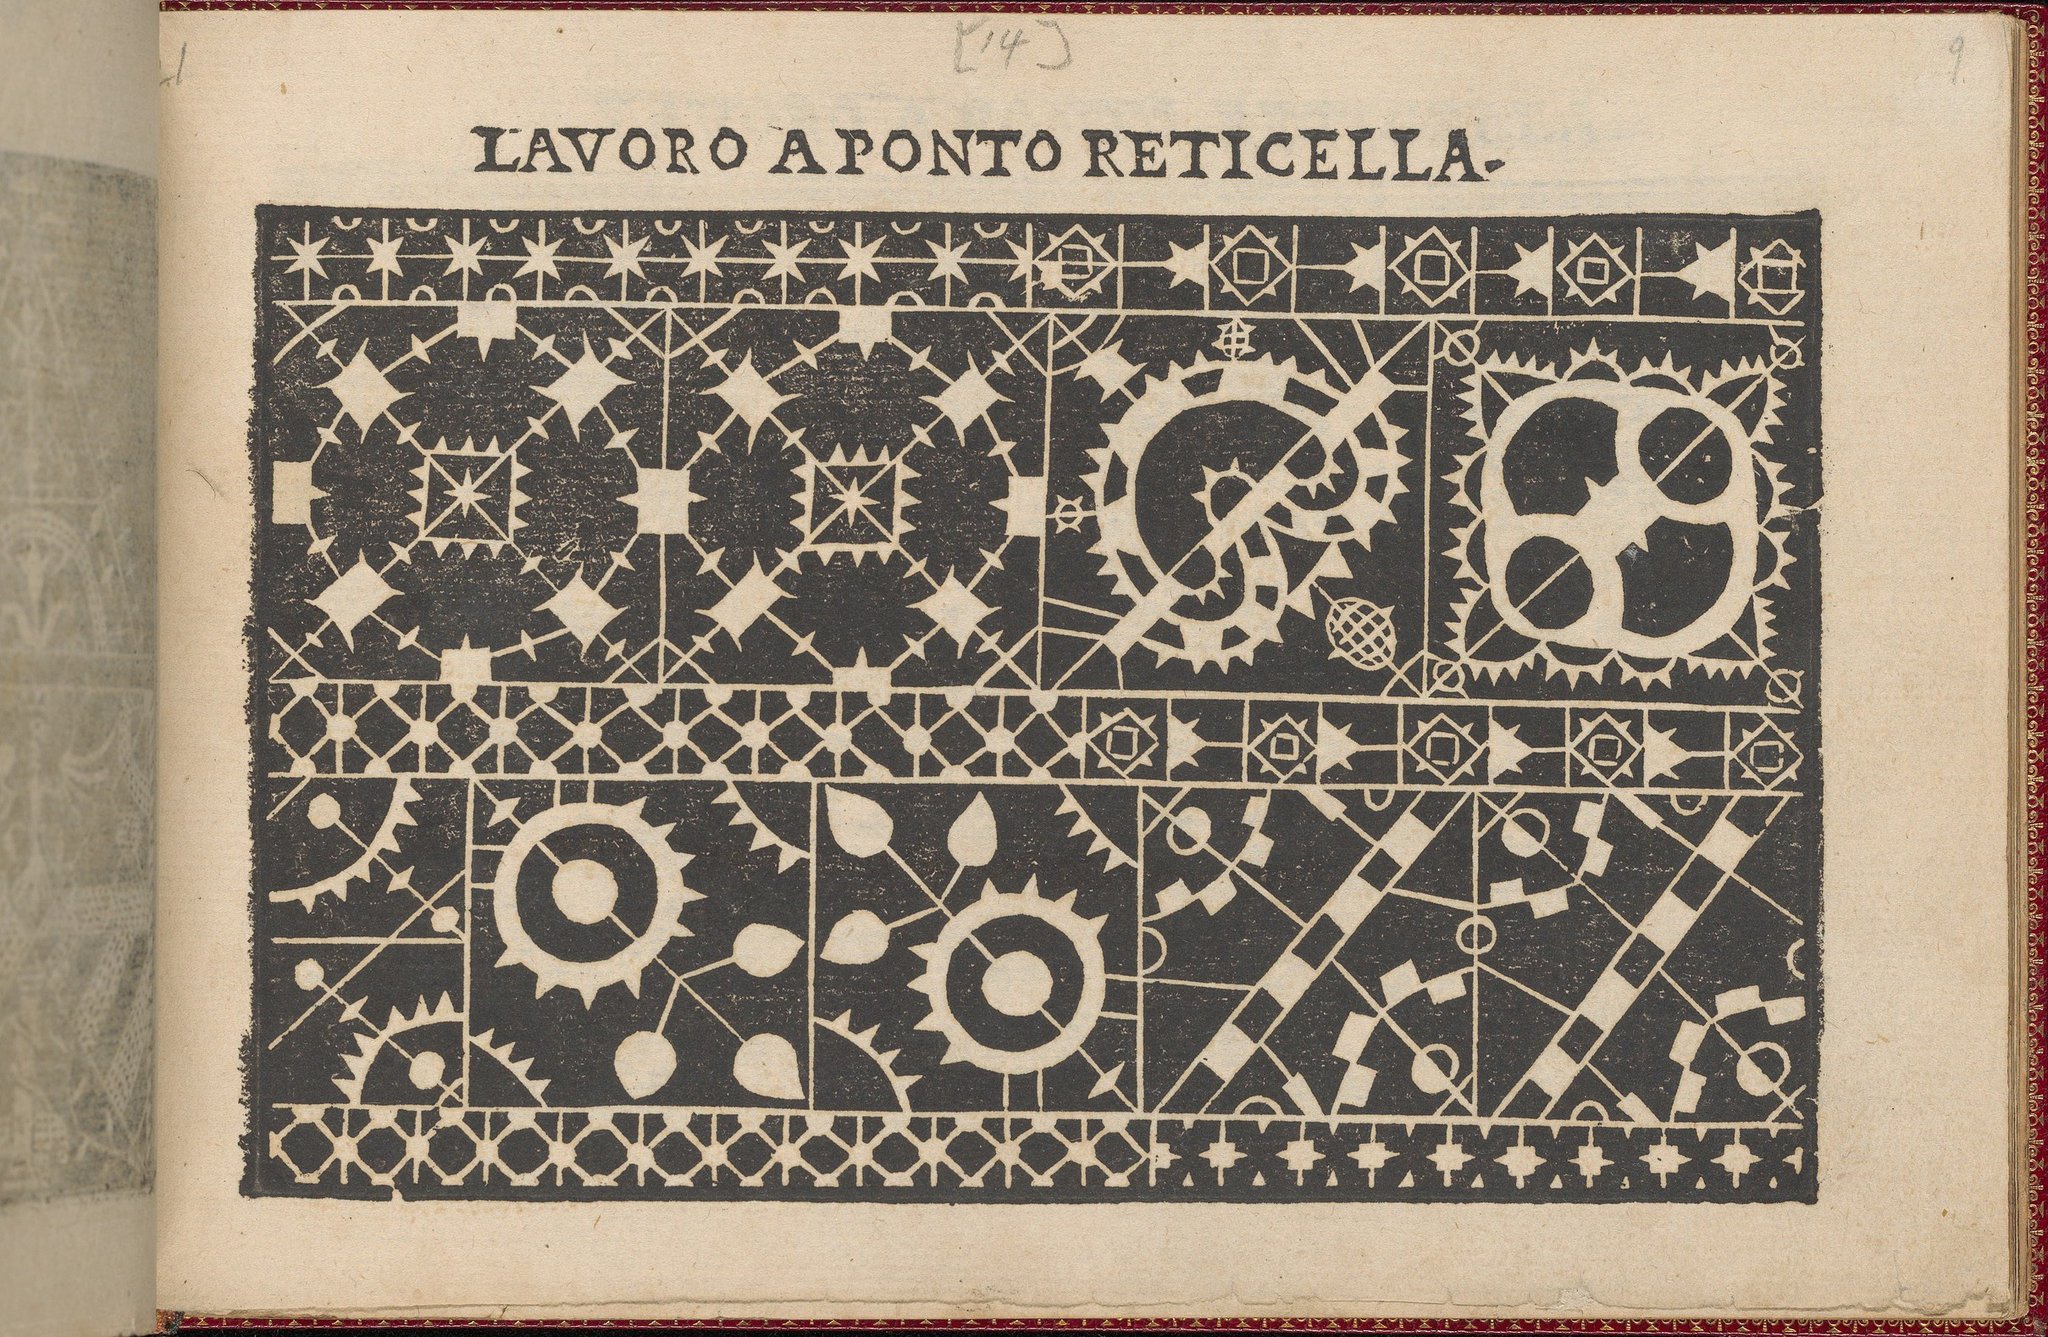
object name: book print ornament architecture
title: Pretiosa Gemma delle virtuose donne, page 11 (recto)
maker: isabella catanea parasole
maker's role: author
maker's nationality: italian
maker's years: 1565-1625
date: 1600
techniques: woodcut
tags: ornament